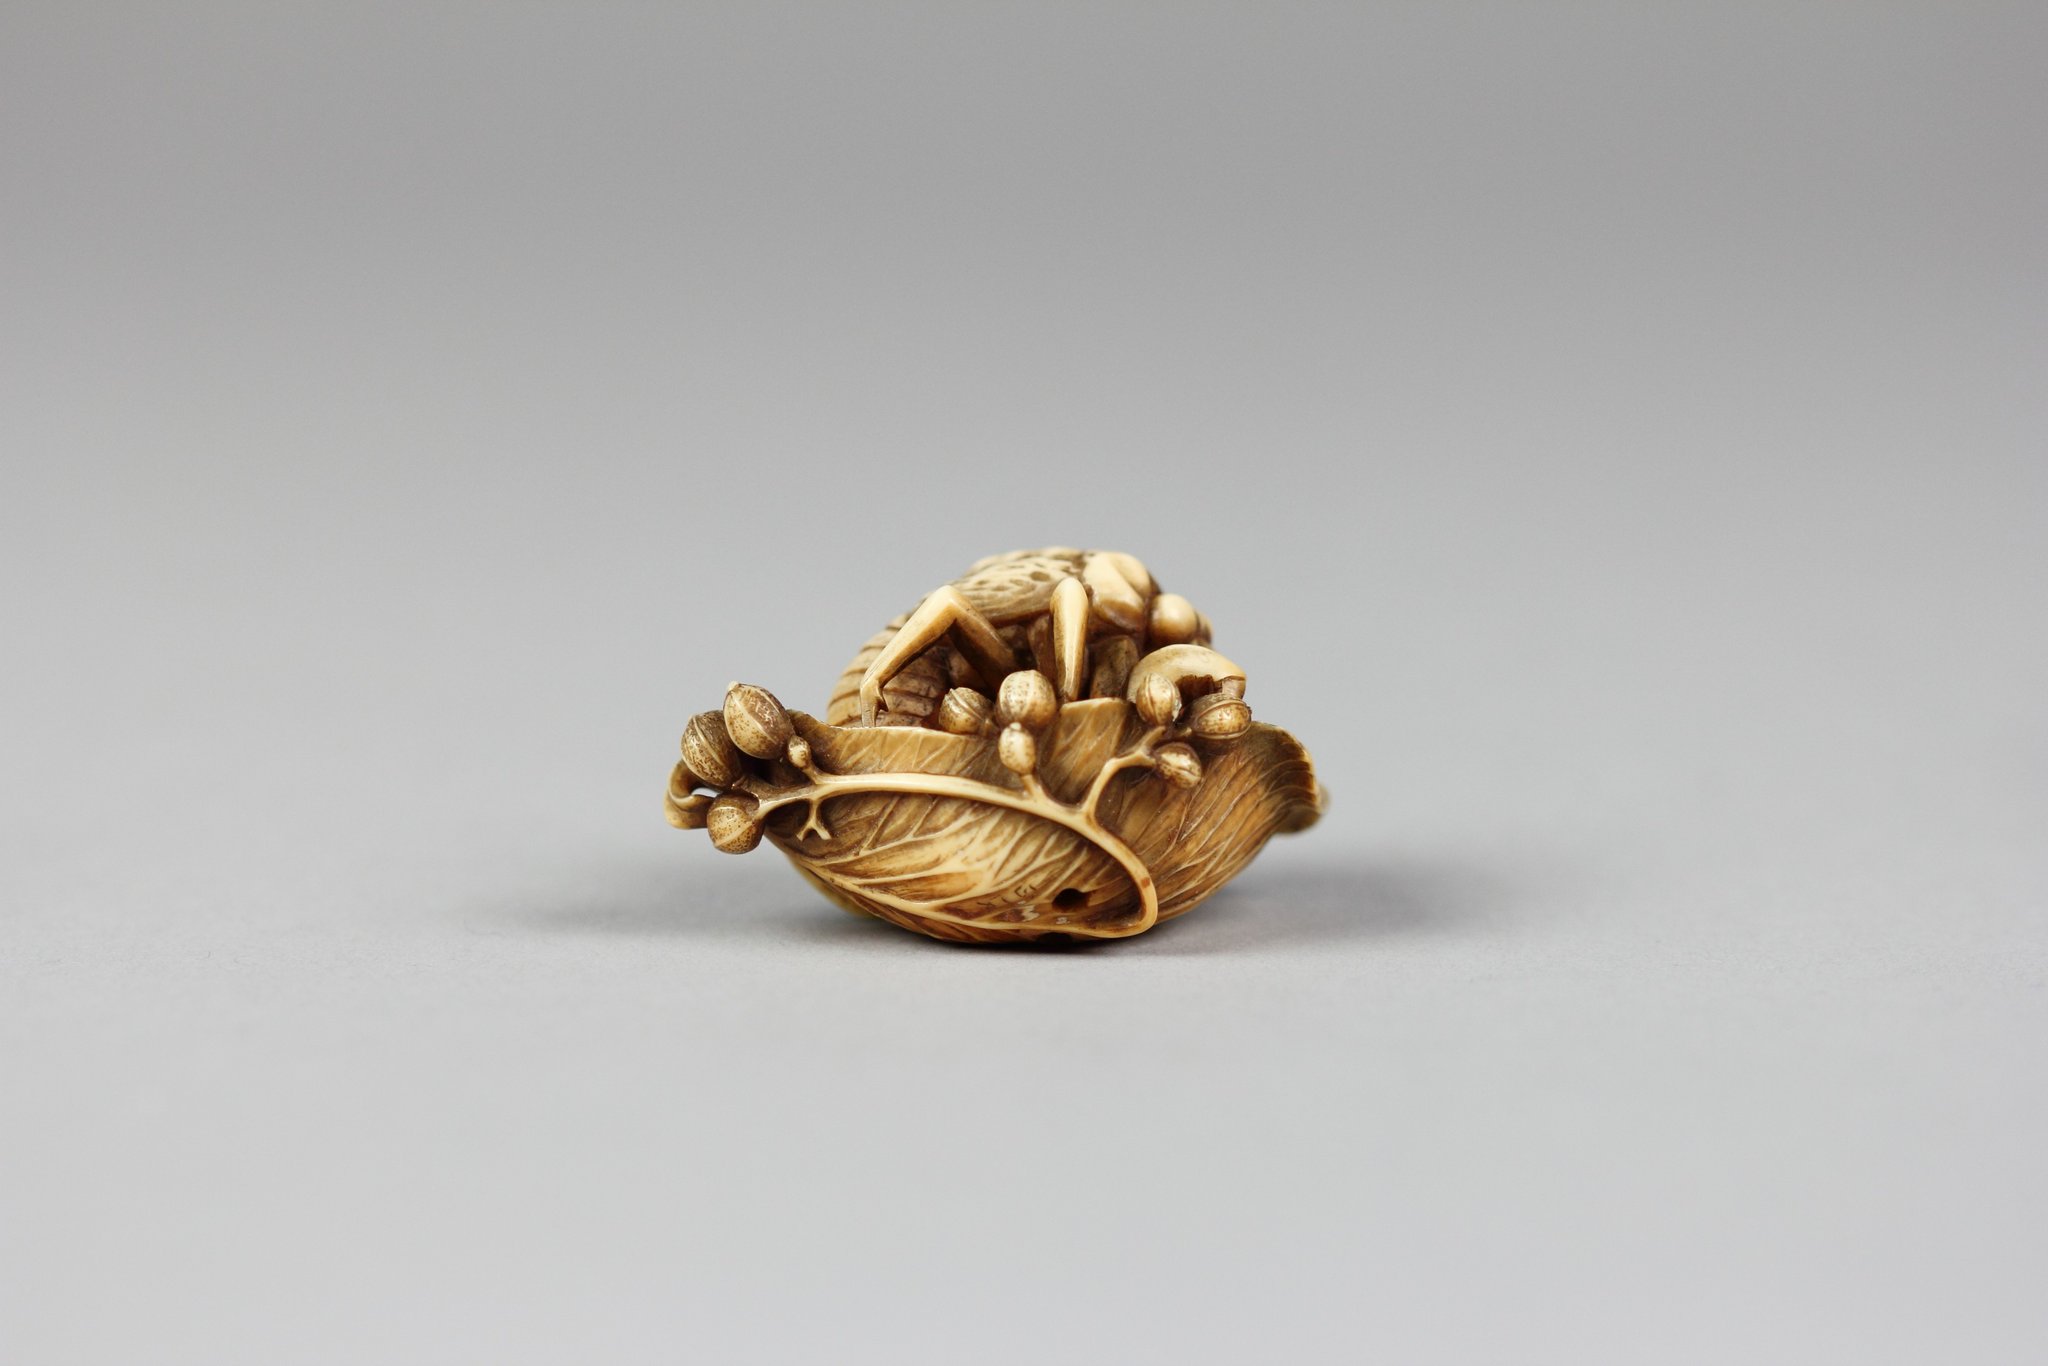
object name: netsuke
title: Netsuke of Bee on a Leaf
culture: japanese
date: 1801-1900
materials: ivory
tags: bees,leaves